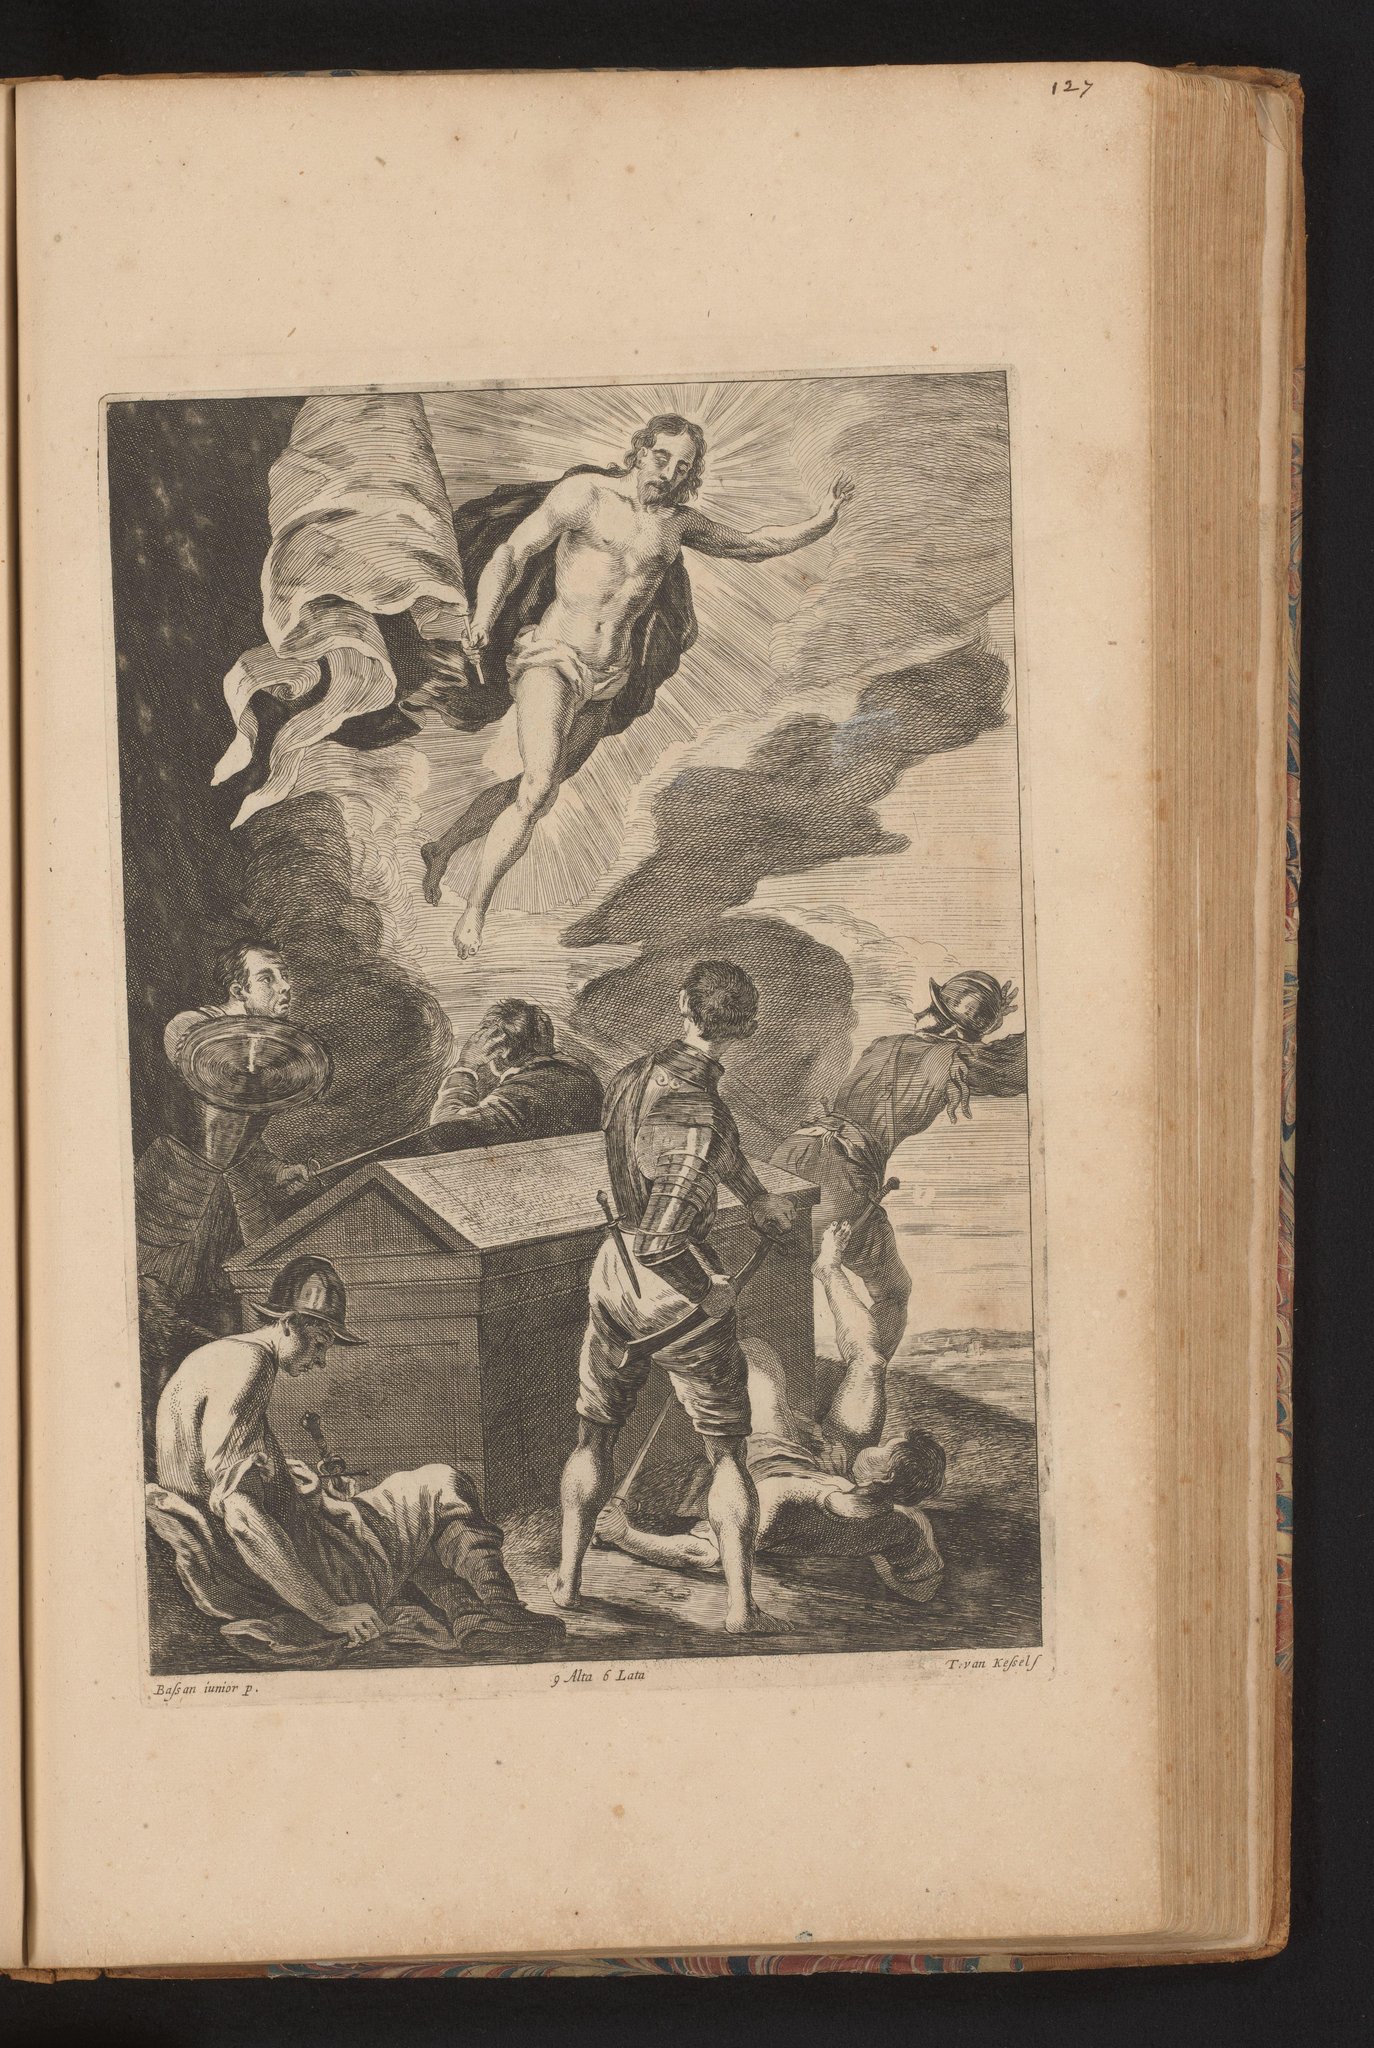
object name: print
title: Opstanding van Christus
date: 1660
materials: paper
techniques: etching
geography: southern netherlands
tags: christ, usually holding a banner, arises from the grave; often combined with sleeping and/or frightened soldiers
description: David Teniers heeft waarschijnlijk van alle schilderijen uit de collectie van Leopold Willem van Oostenrijk een olieverfstudie op doek of paneel vervaardigd (zgn. pasticcio), die als voorbeeld voor de prentmakers diende. Het is niet altijd duidelijk of de pasticci door hem zijn gemaakt of door zijn atelier. Niet alle pasticci zijn overgeleverd.